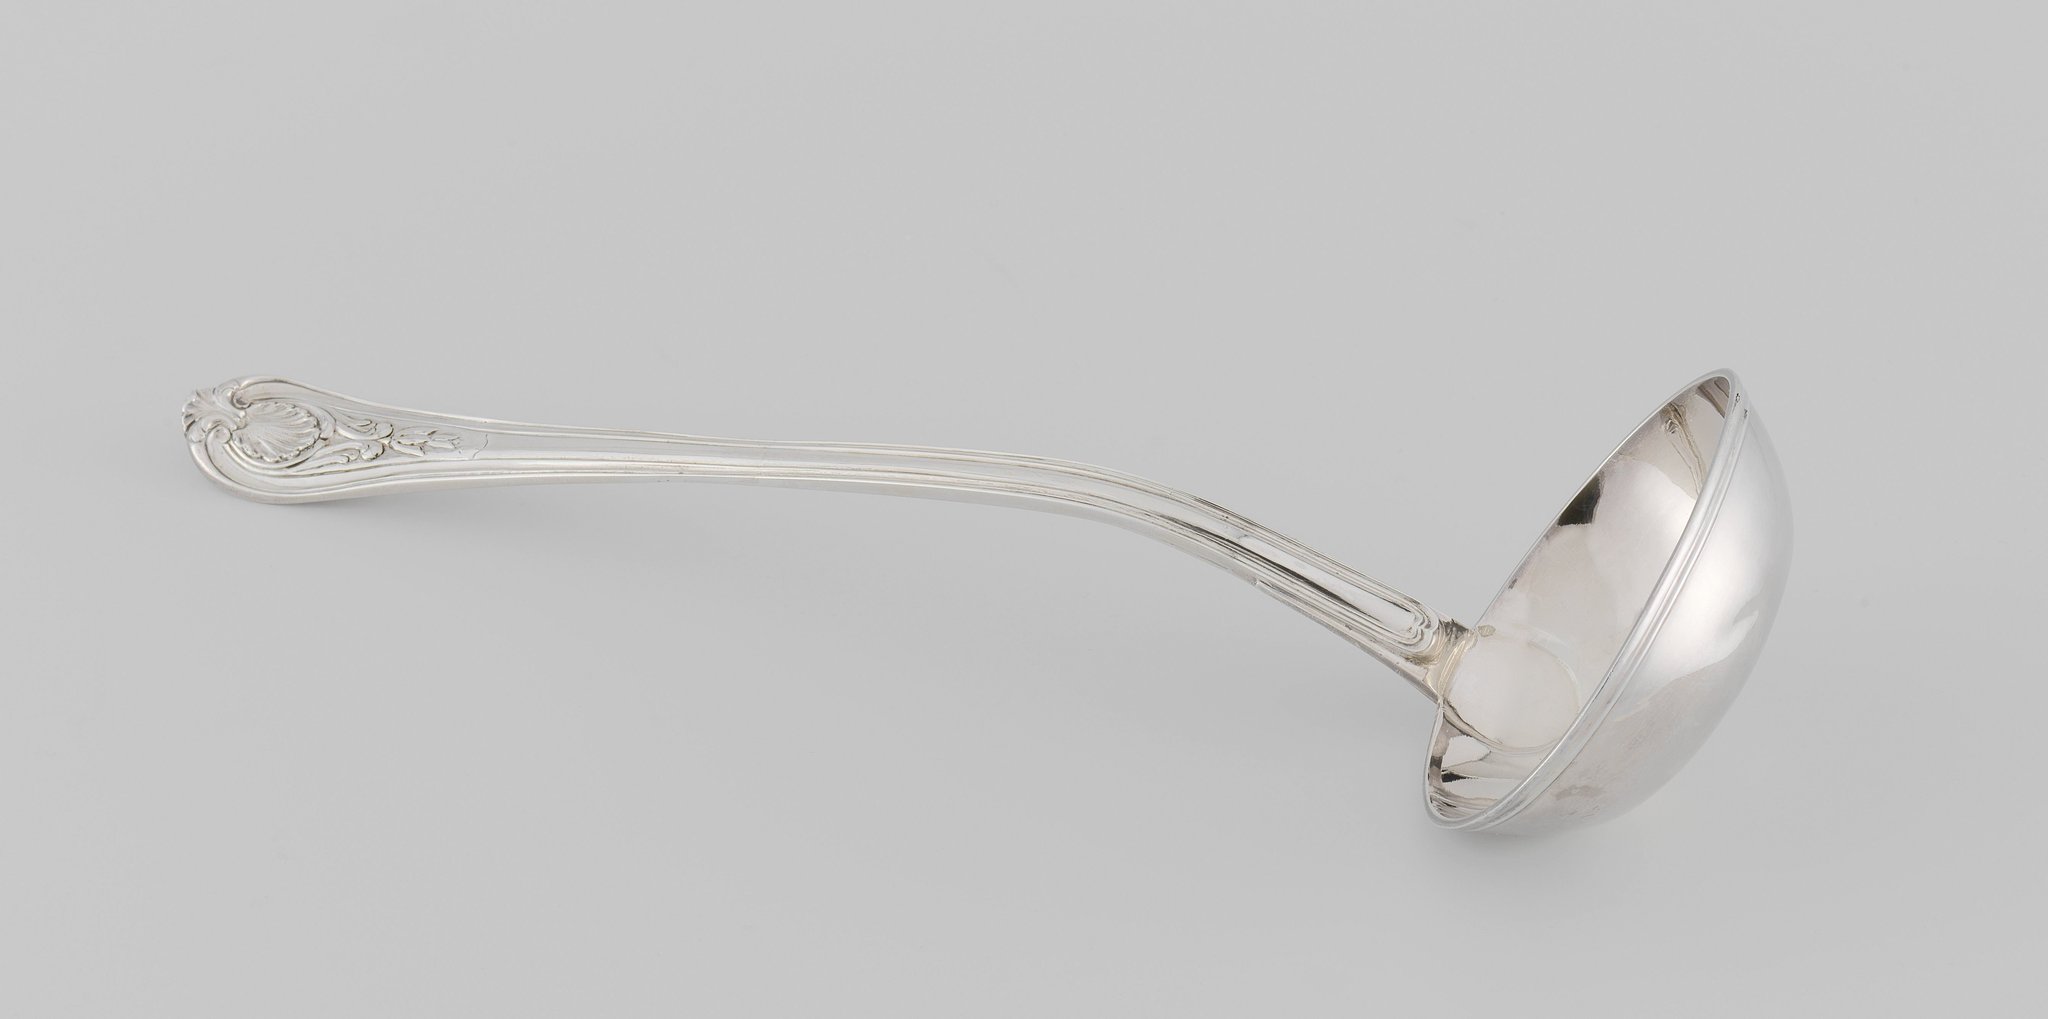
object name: opscheplepel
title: Tureen and stand with a ladle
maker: engelbart joosten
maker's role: silversmith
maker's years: 1717-1789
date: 1772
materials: silver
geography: the hague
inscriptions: signature and date: ‘Merken: Den Haag; kl. leeuw (tweede gehalte); jrl. A (1772); mt. E. Joosten.’, inscription: ‘Op terrine, onderschotel en lepel de gecombineerde wapens gegraveerd van: Assueer Jan baron Torck, heer van Rosendael, Duivenvoorde, Petkum, Harselo, Voorschoten, Veur en Eusebia Jacoba de Rode van Heeckeren.’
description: This tureen and stand bear the alliance coat of arms of Baron Assueer Jan Torck and Eusebia Jacoba de Rode van Heeckeren, who were married in 1758. This couple was closely acquainted with the stadtholder and his consort. The imposing tureen, an early example of Neoclassical Hague silver, affords a good impression of the art at and around the stadtholder’s court.